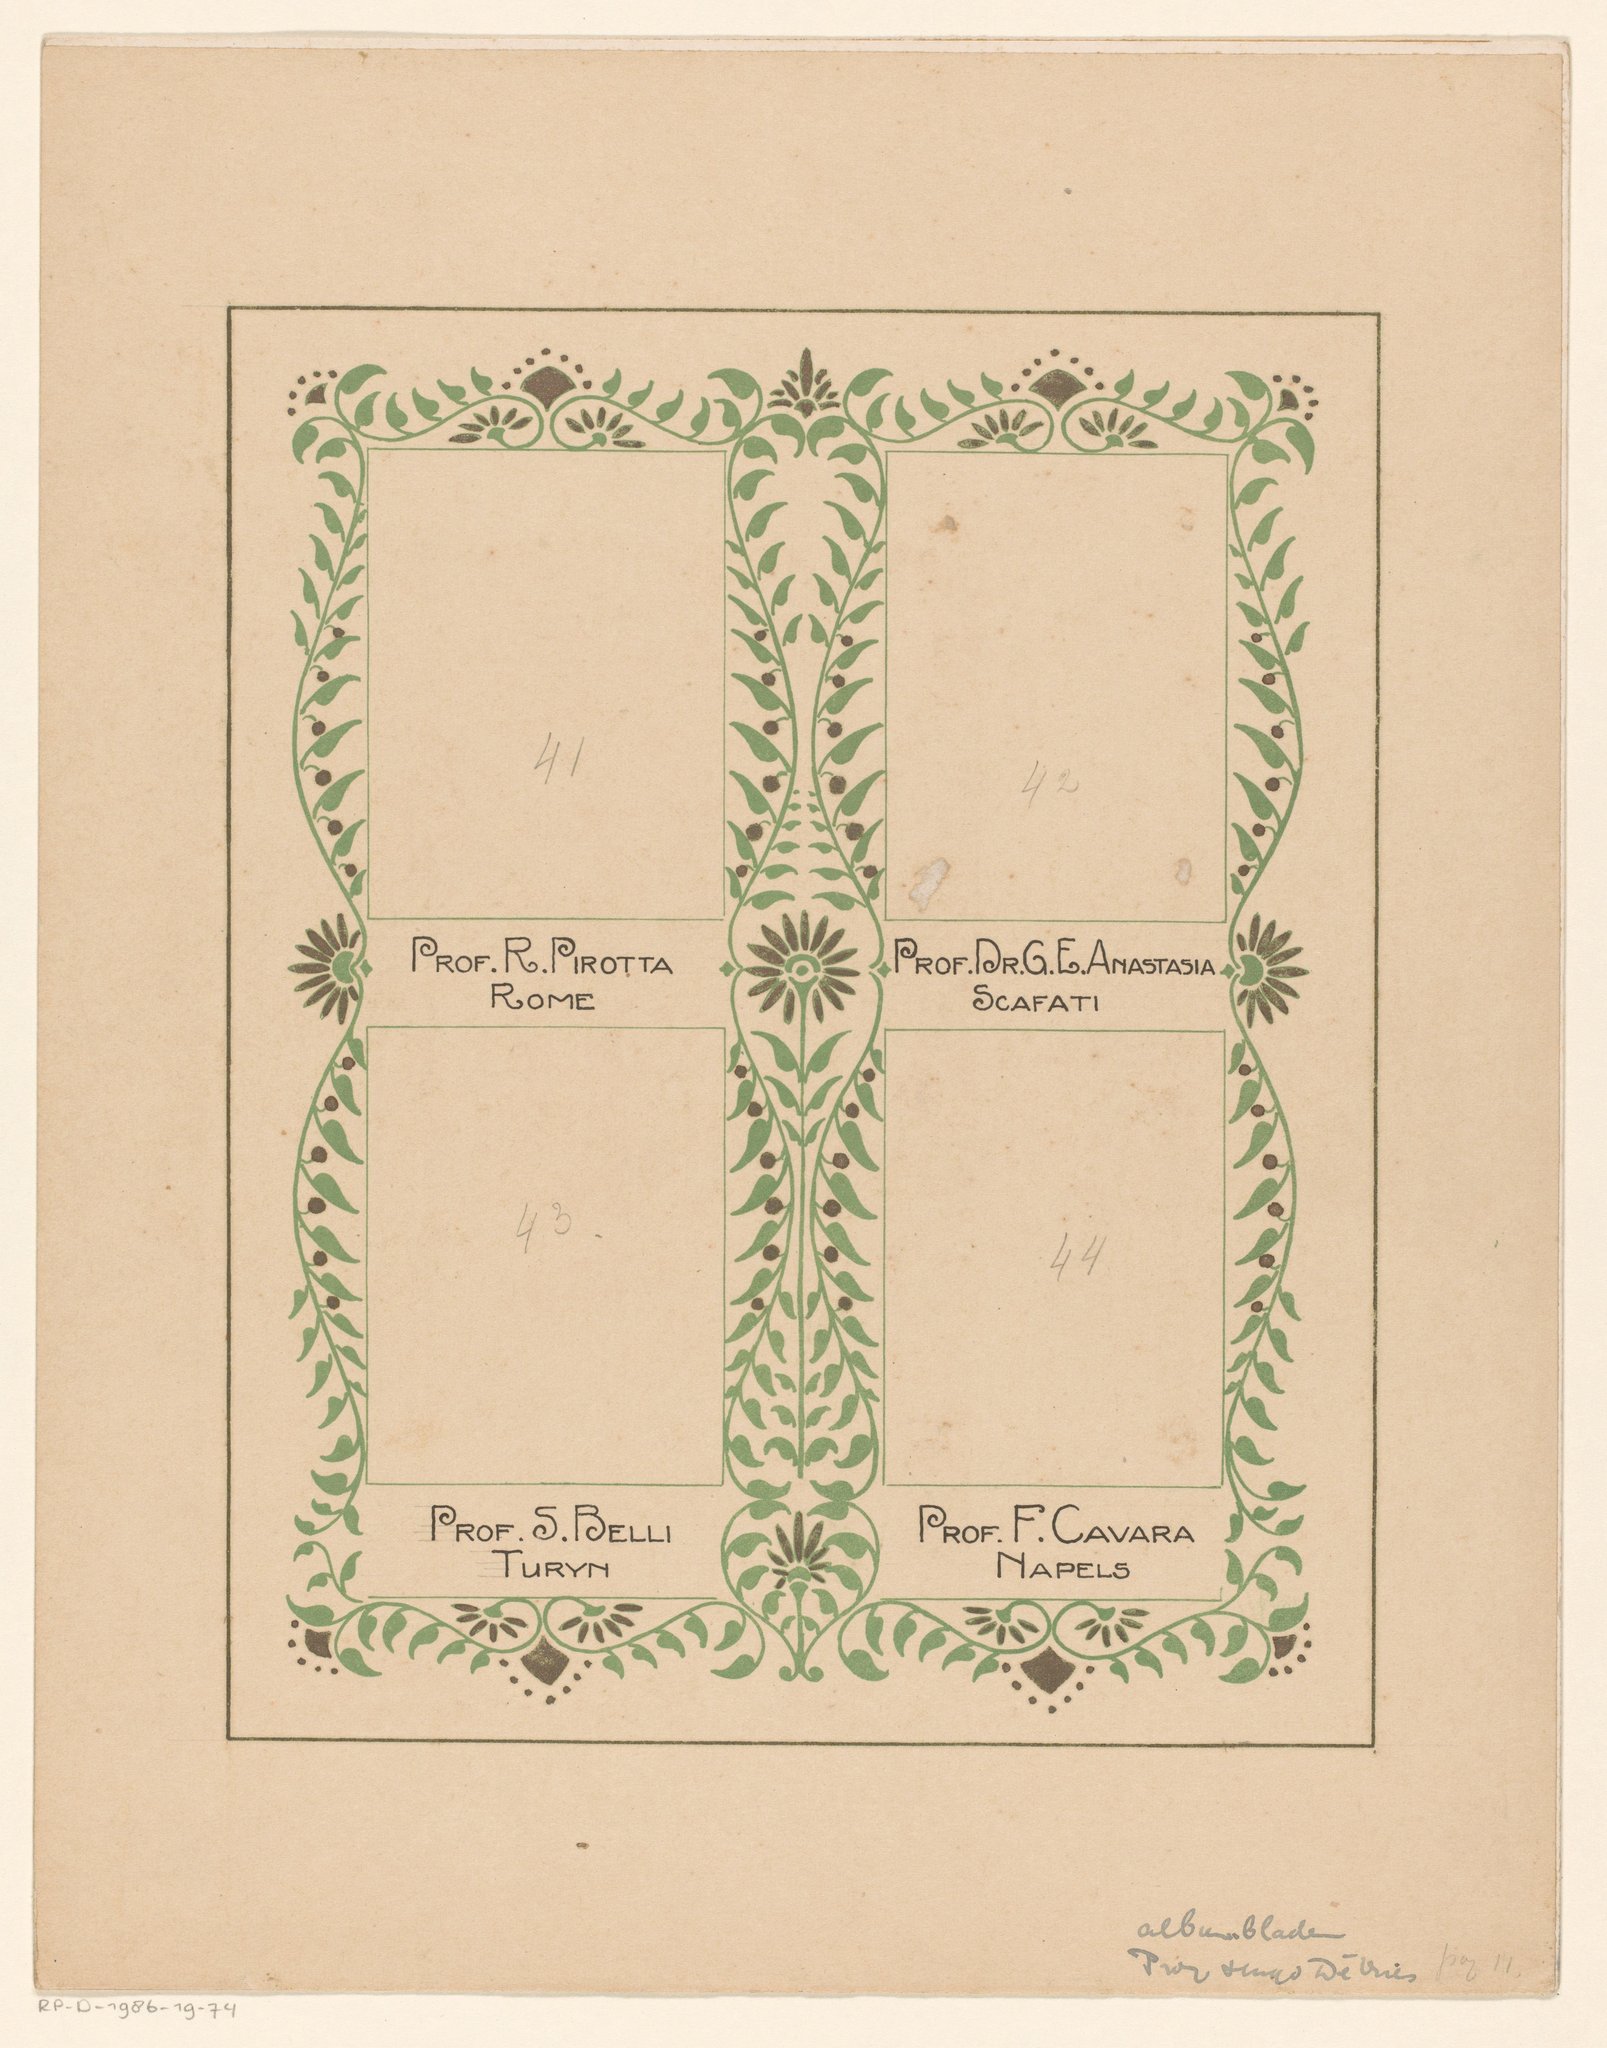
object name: design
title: Albumblad voor een album voor Prof. Hugo de Vries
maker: reinier willem petrus de vries (1874-1953)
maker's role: draughtsman, print maker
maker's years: 1874-1953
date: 1918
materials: paint, ink, paper, pencil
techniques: brush, lithograph, pen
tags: haarlem, hugo de vries, foliage, tendrils, branches ~ ornament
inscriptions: collector's mark: ‘R:MVS.’, annotation: ‘albumbladen/ Prof Hugo De Vries pag 11.’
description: Rechthoekig kader met bloem- en bladornamenten met daarin vier vakken voor portretten met onder elk vak de naam van de geportretteerde.